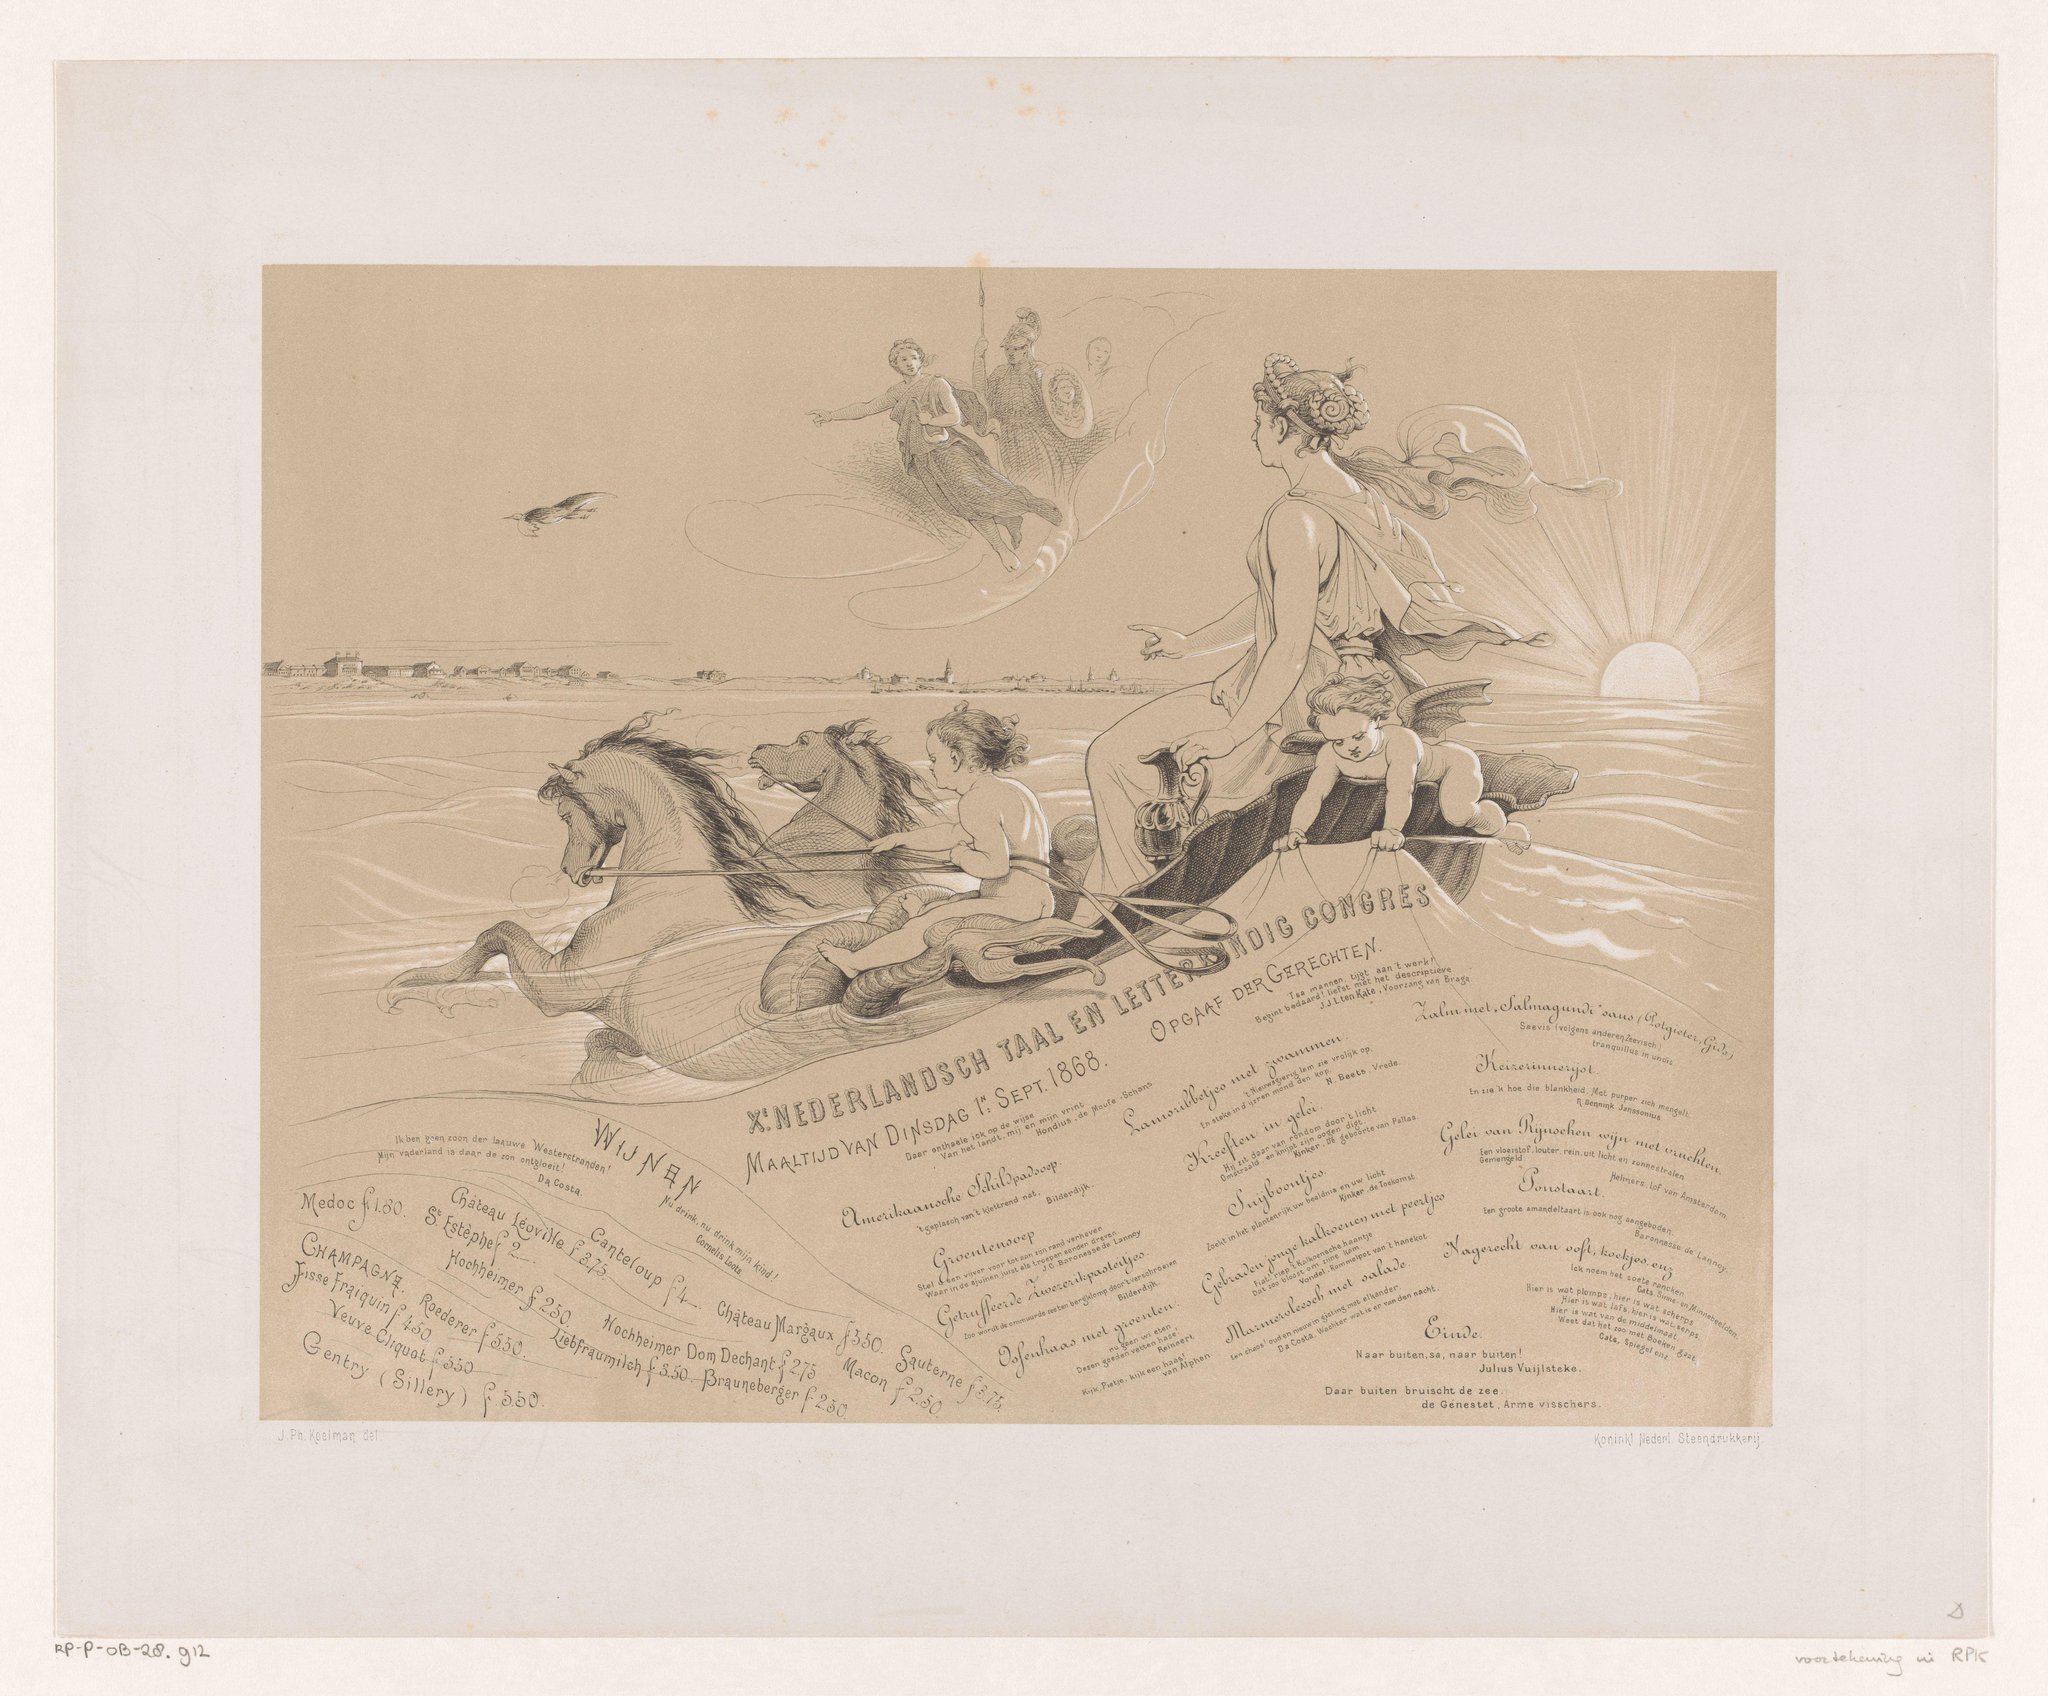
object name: print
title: Menu ter gelegenheid van het tiende Nederlands taal en letterkundig congres 1868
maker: johan philip koelman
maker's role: draughtsman, painter, print maker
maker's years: 1818-1893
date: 1868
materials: paper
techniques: tone lithography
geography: netherlands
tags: triumph of aurora: in her chariot drawn by two (sometimes four) horses, and possibly scattering flowers; aurora's victory over the night; 'carro dell'aurora' (ripa)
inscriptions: collector's mark: Lugt 2228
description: Menukaart van de gerechten geserveerd bij het Xe Nederlandsch Taal- en Letterkundig Congres te Scheveningen op 1 september 1868. Aurora rijdt in een wagen getrokken door zeepaarden over zee richting de kust naar het Stedelijk Badhuis te Scheveningen. Een putto houdt boven de golven een doek op waarop de gerechten en de wijnen staan vermeld. Vanuit de wolken wijzen figuren, waaronder Minerva, de weg.